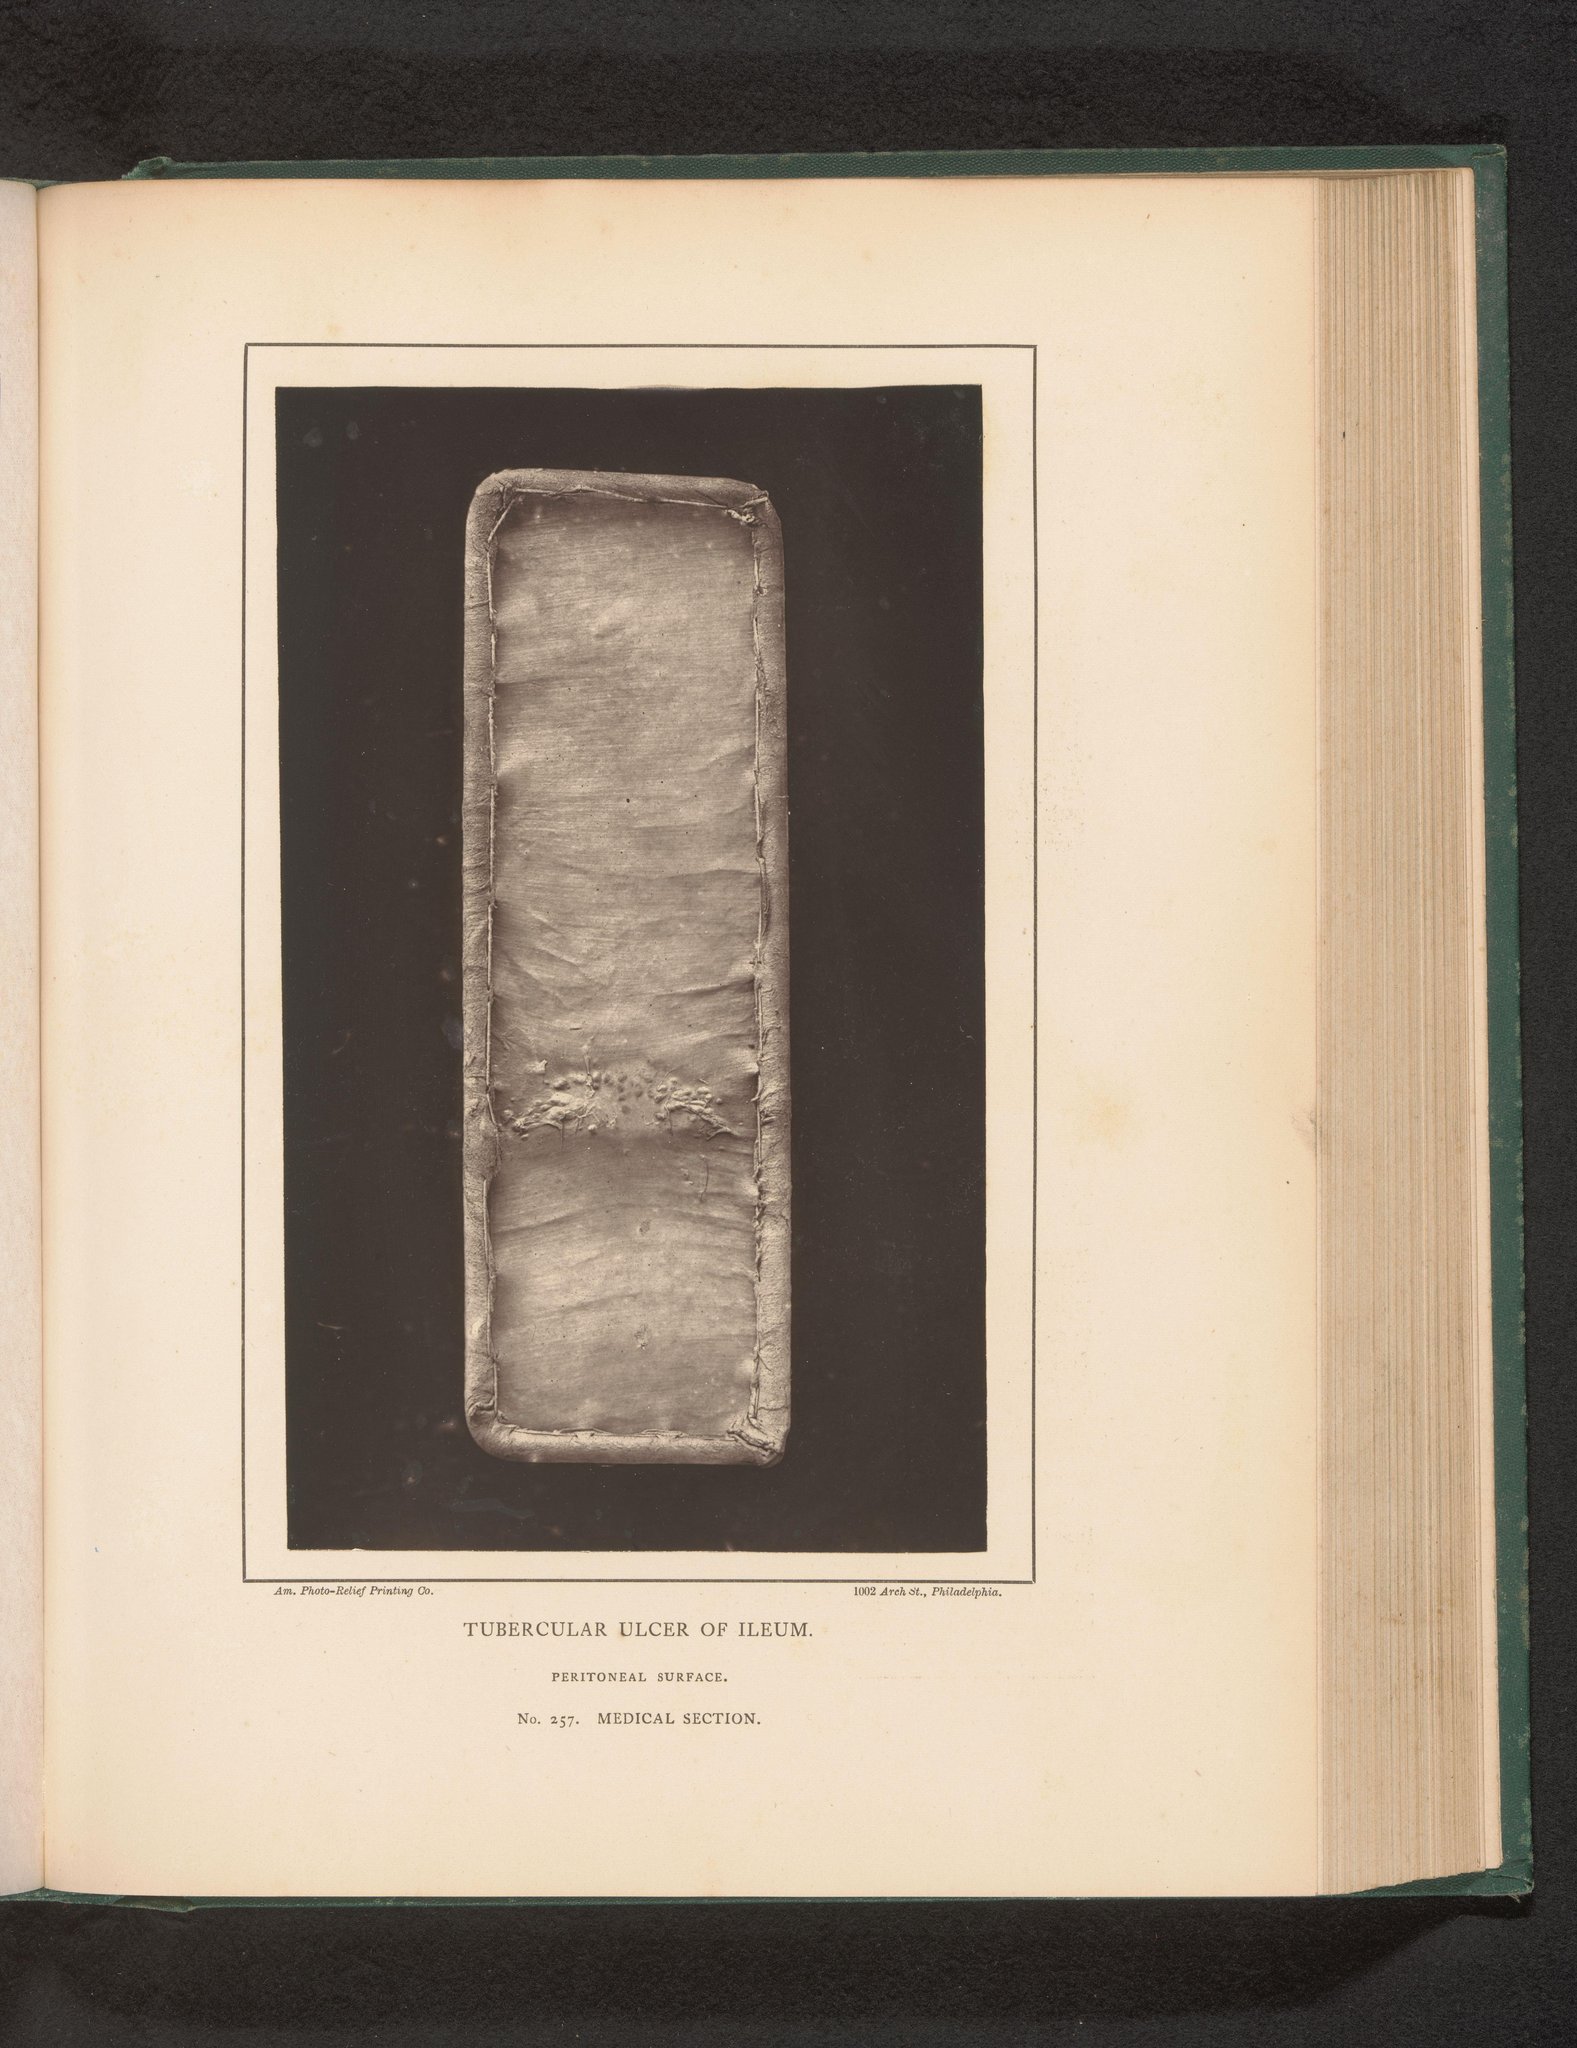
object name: photomechanical print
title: Opgespannen stuk kronkeldarm met een zweer door tuberculose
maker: edward j. ward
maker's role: fotograaf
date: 1874-1879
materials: paper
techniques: woodburytype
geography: philadelphia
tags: intestines, ulcer, anatomical specimen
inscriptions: number: ‘Peritoneal surface./ No. 257. MEDICAL SECTION.’, address: ‘1002 Arch St., Philadelphia.’